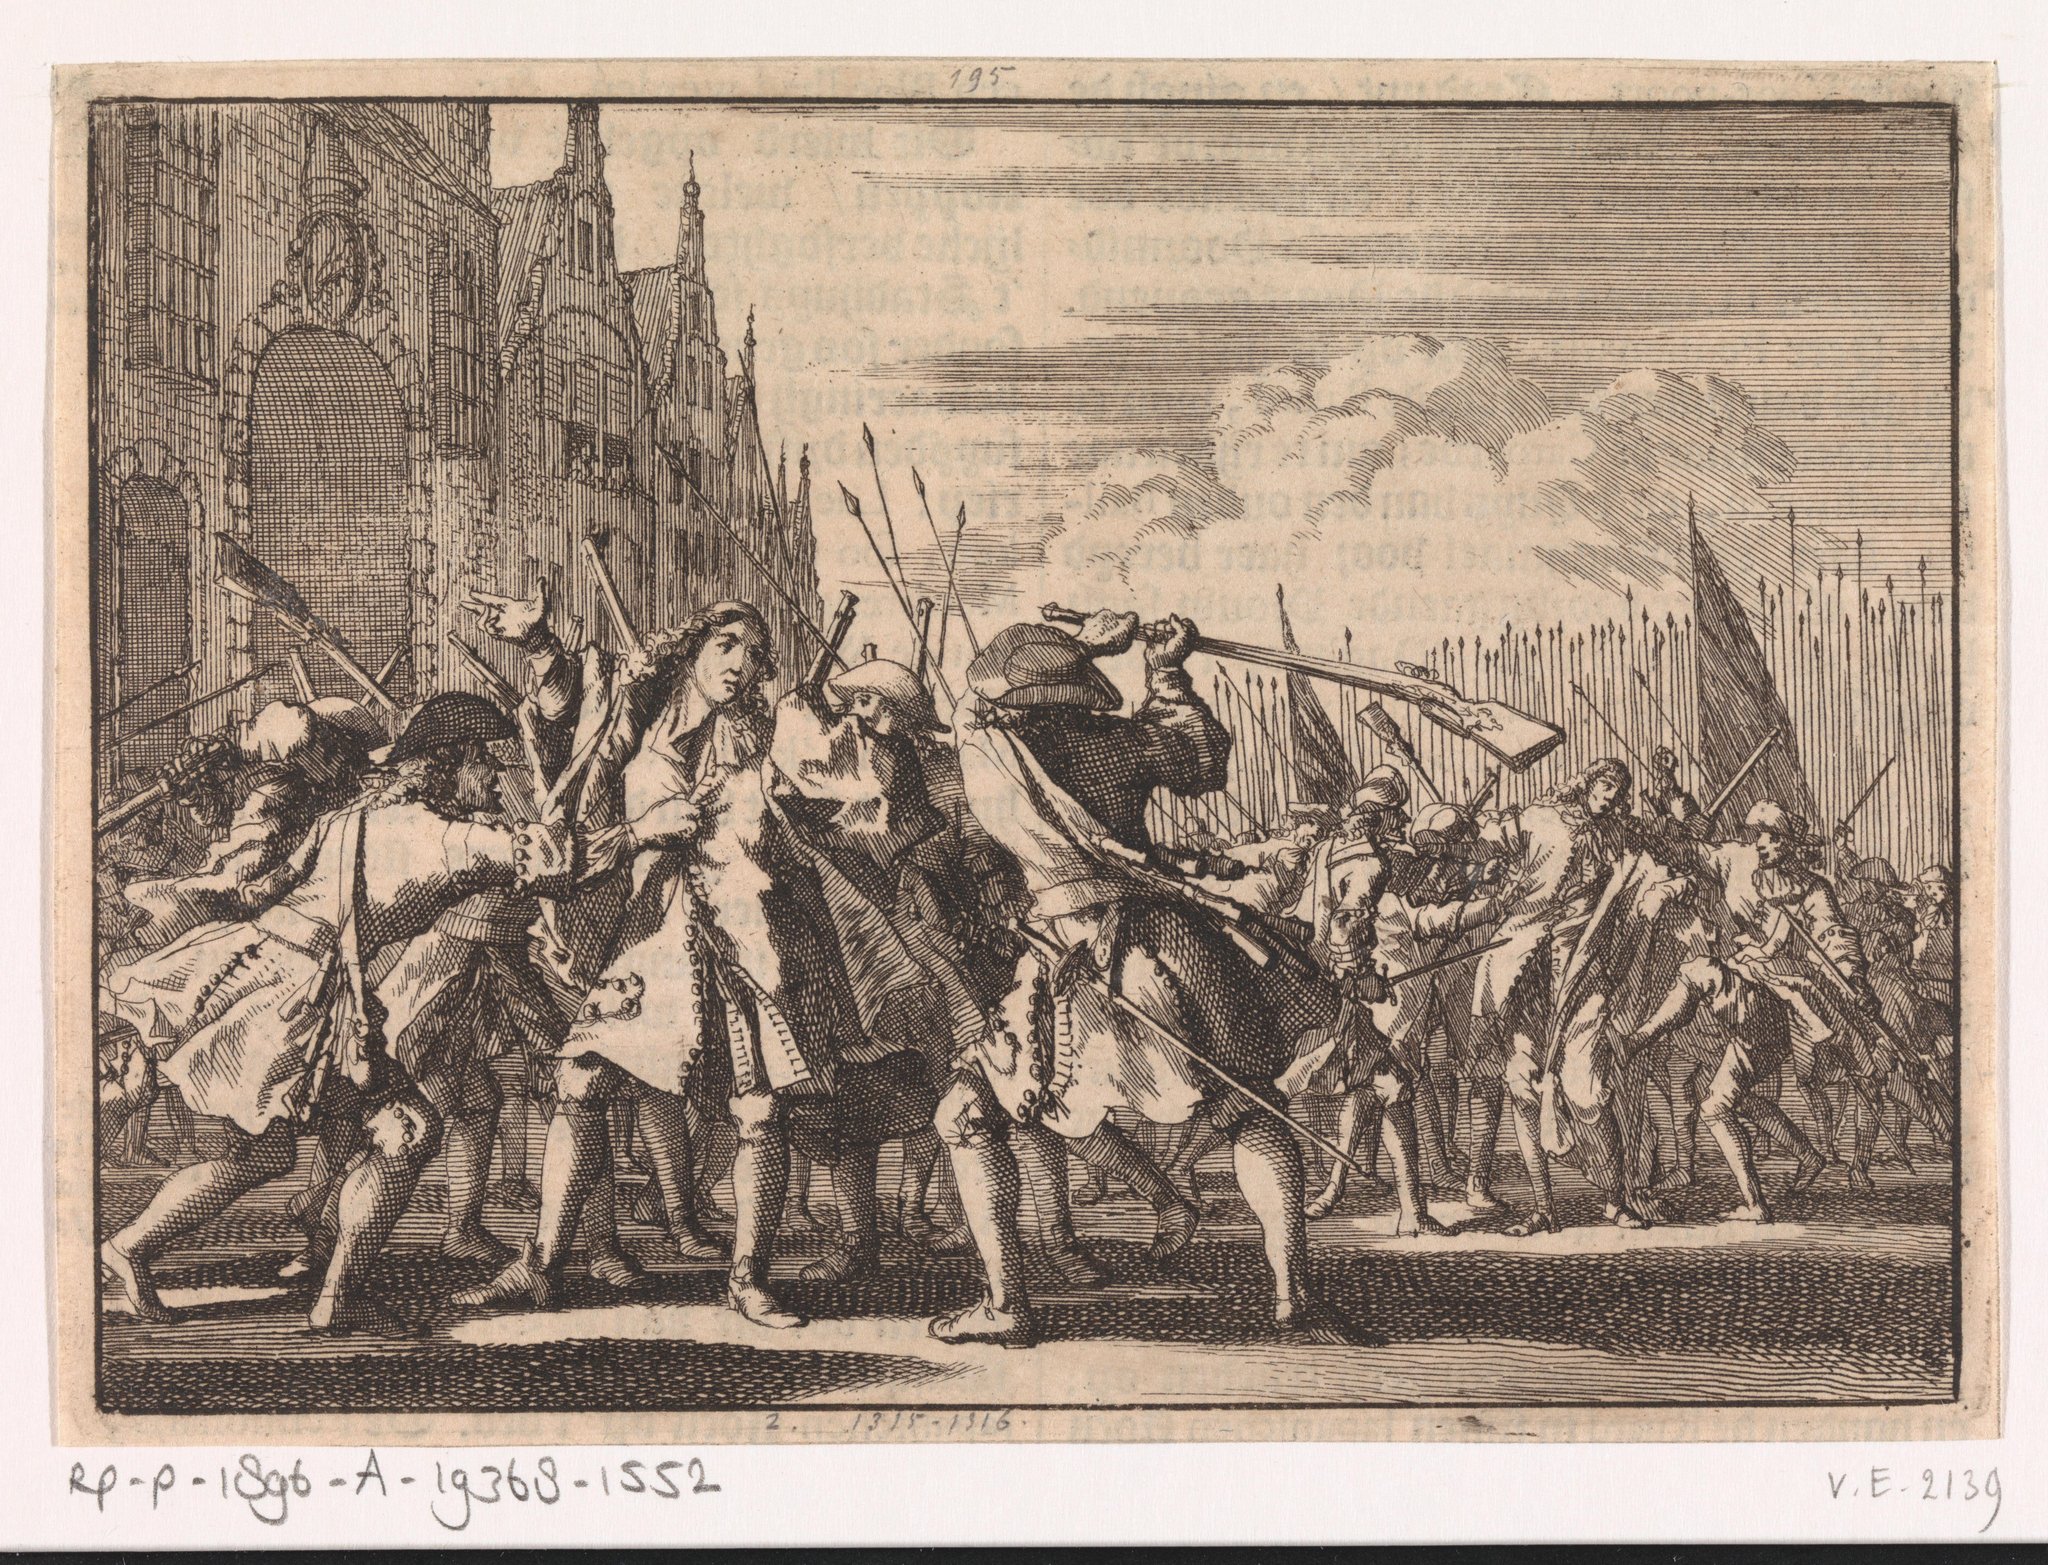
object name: print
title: Moord op de gebroeders De Witt, 1672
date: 1698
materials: paper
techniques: etching, letterpress printing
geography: amsterdam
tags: dordrecht, the hague, cornelis de witt, politician, johan de witt, lynching, attempt, political murder, violent death, being killed; being mishandled and maltreated; seeking death (+ death by lynching)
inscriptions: collector's mark: Lugt 2228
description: Illustratie uit: Gottfried, Johann Ludwig. Historische kronyck; vervattende een (...) beschrijvingh der aldergedenckwaerdigste geschiedenissen des weerelds, van den aenvangh der scheppingh tot (...) 1576 (2 delen). Leiden: Pieter van der Aa, 1698, dl. II, p. 1315.